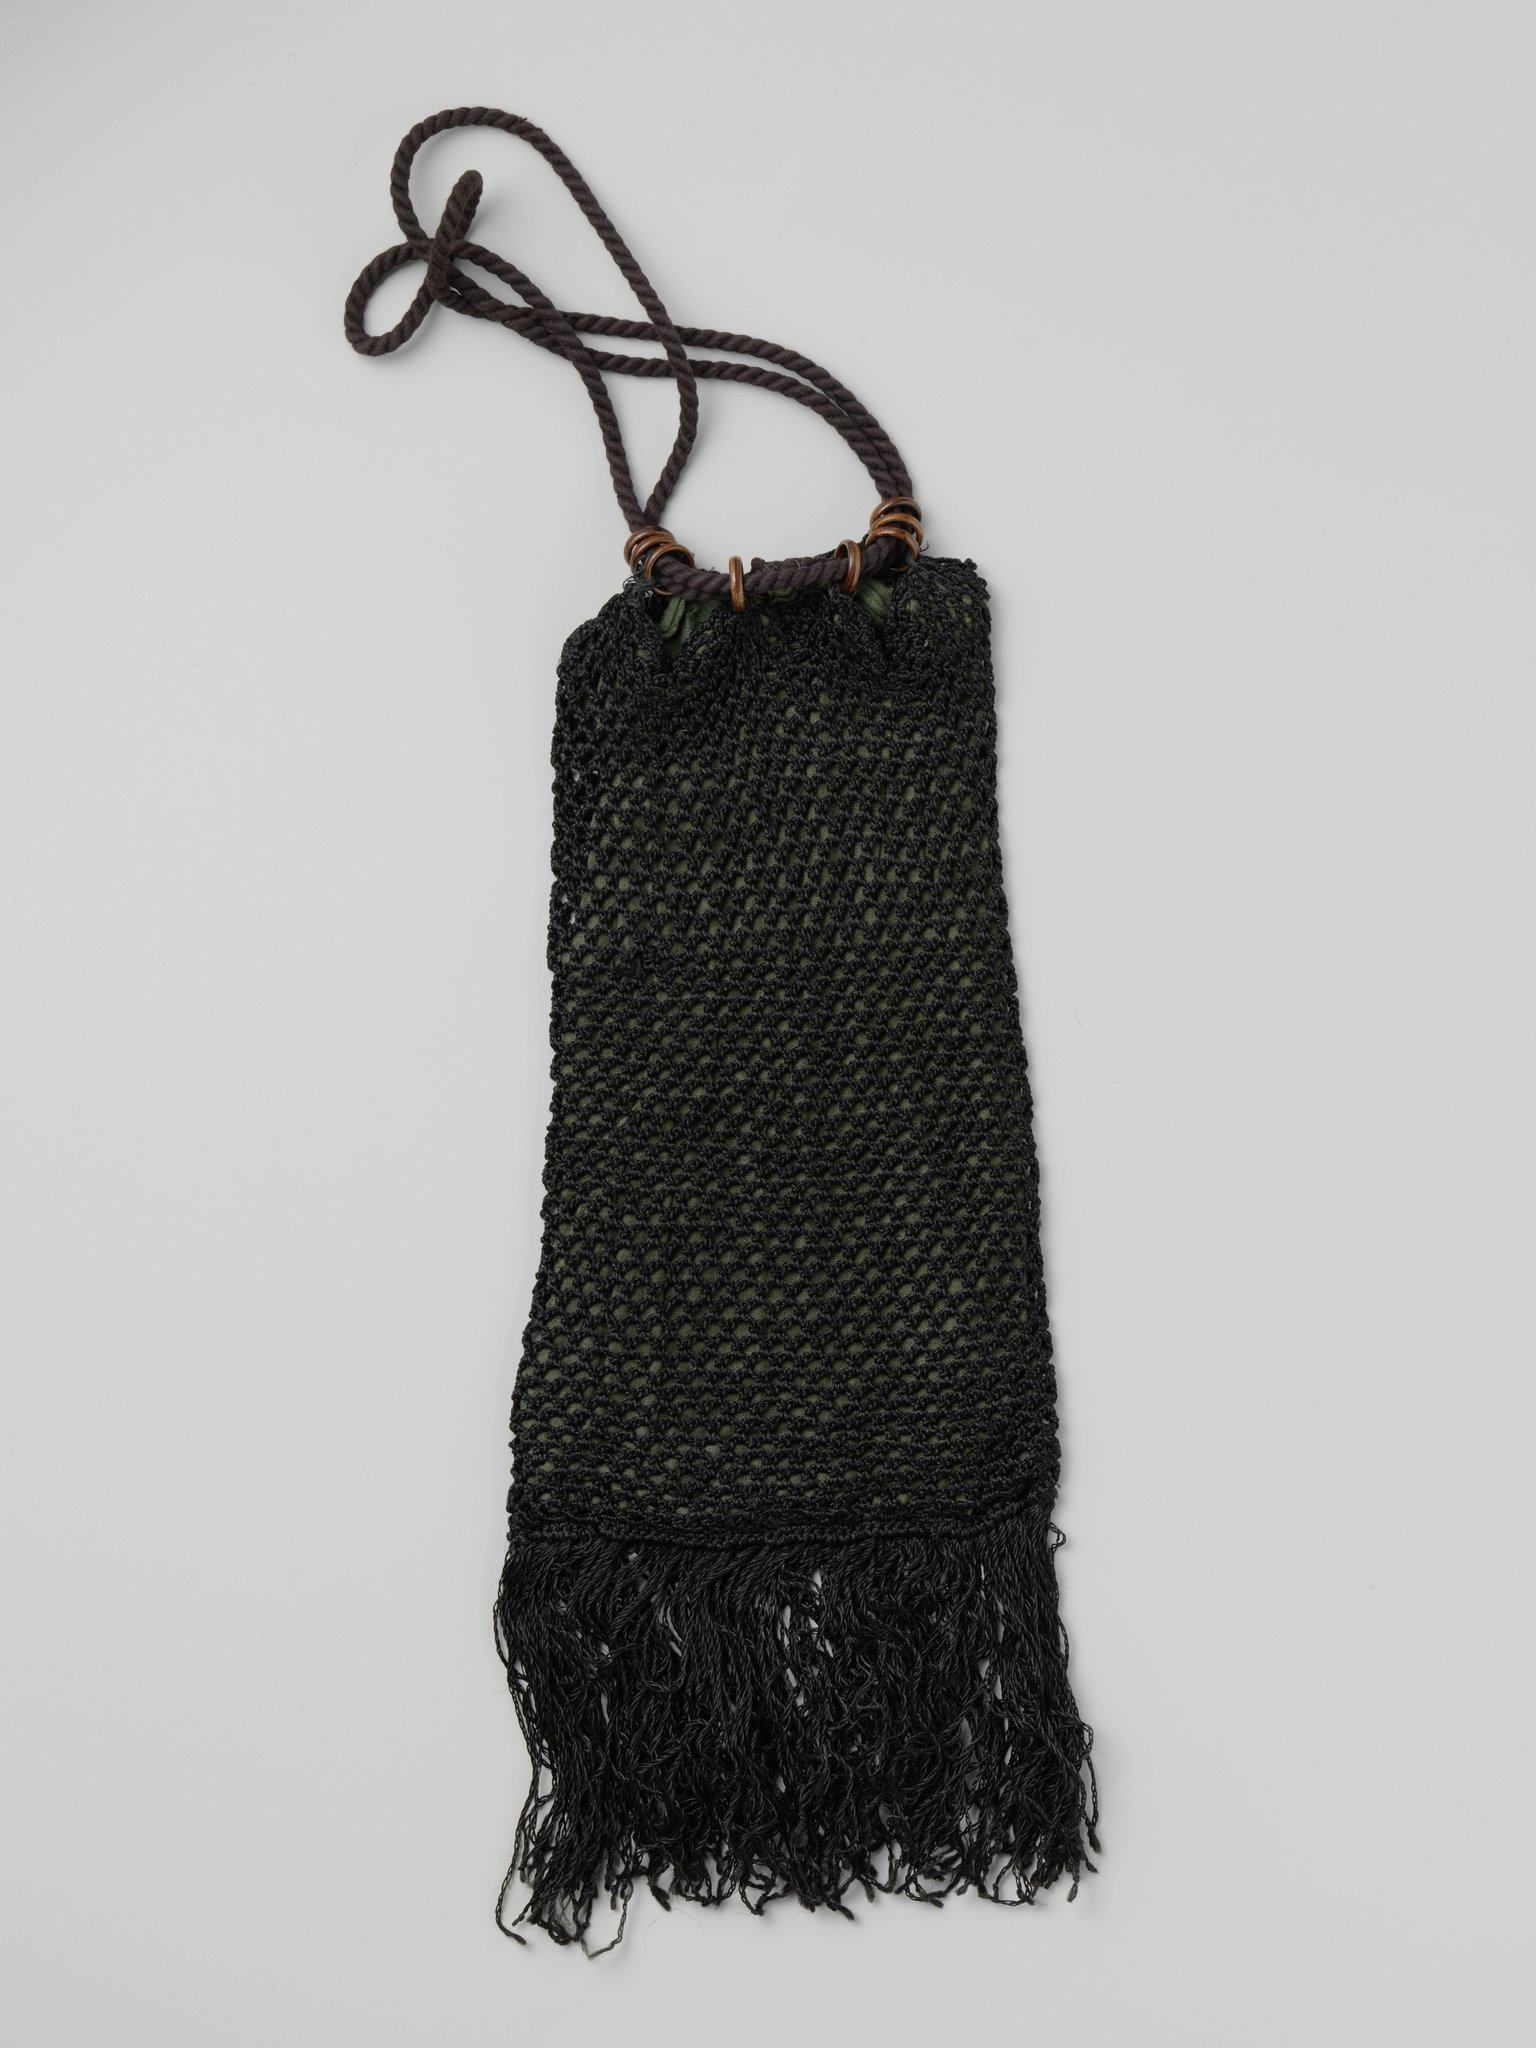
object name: reticule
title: Reticule in een langwerpig model van gehaakte zwarte koordzijde, gevoerd met donkergroene katoen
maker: Anonymous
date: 1925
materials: cotton, plastic, silk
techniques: crochet, turning, weave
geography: netherlands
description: Reticule in een langwerpig model van gehaakte zwarte koordzijde, in een gelijkmatig mazennetwerk, dat eindigt in gedraaide franjes langs de hele onderkant. Aan de bovenrand acht bruine kunststof ringen, waardoor een enkel gedraaid zwart koord. De tas is gevoerd met donkergroene katoen.